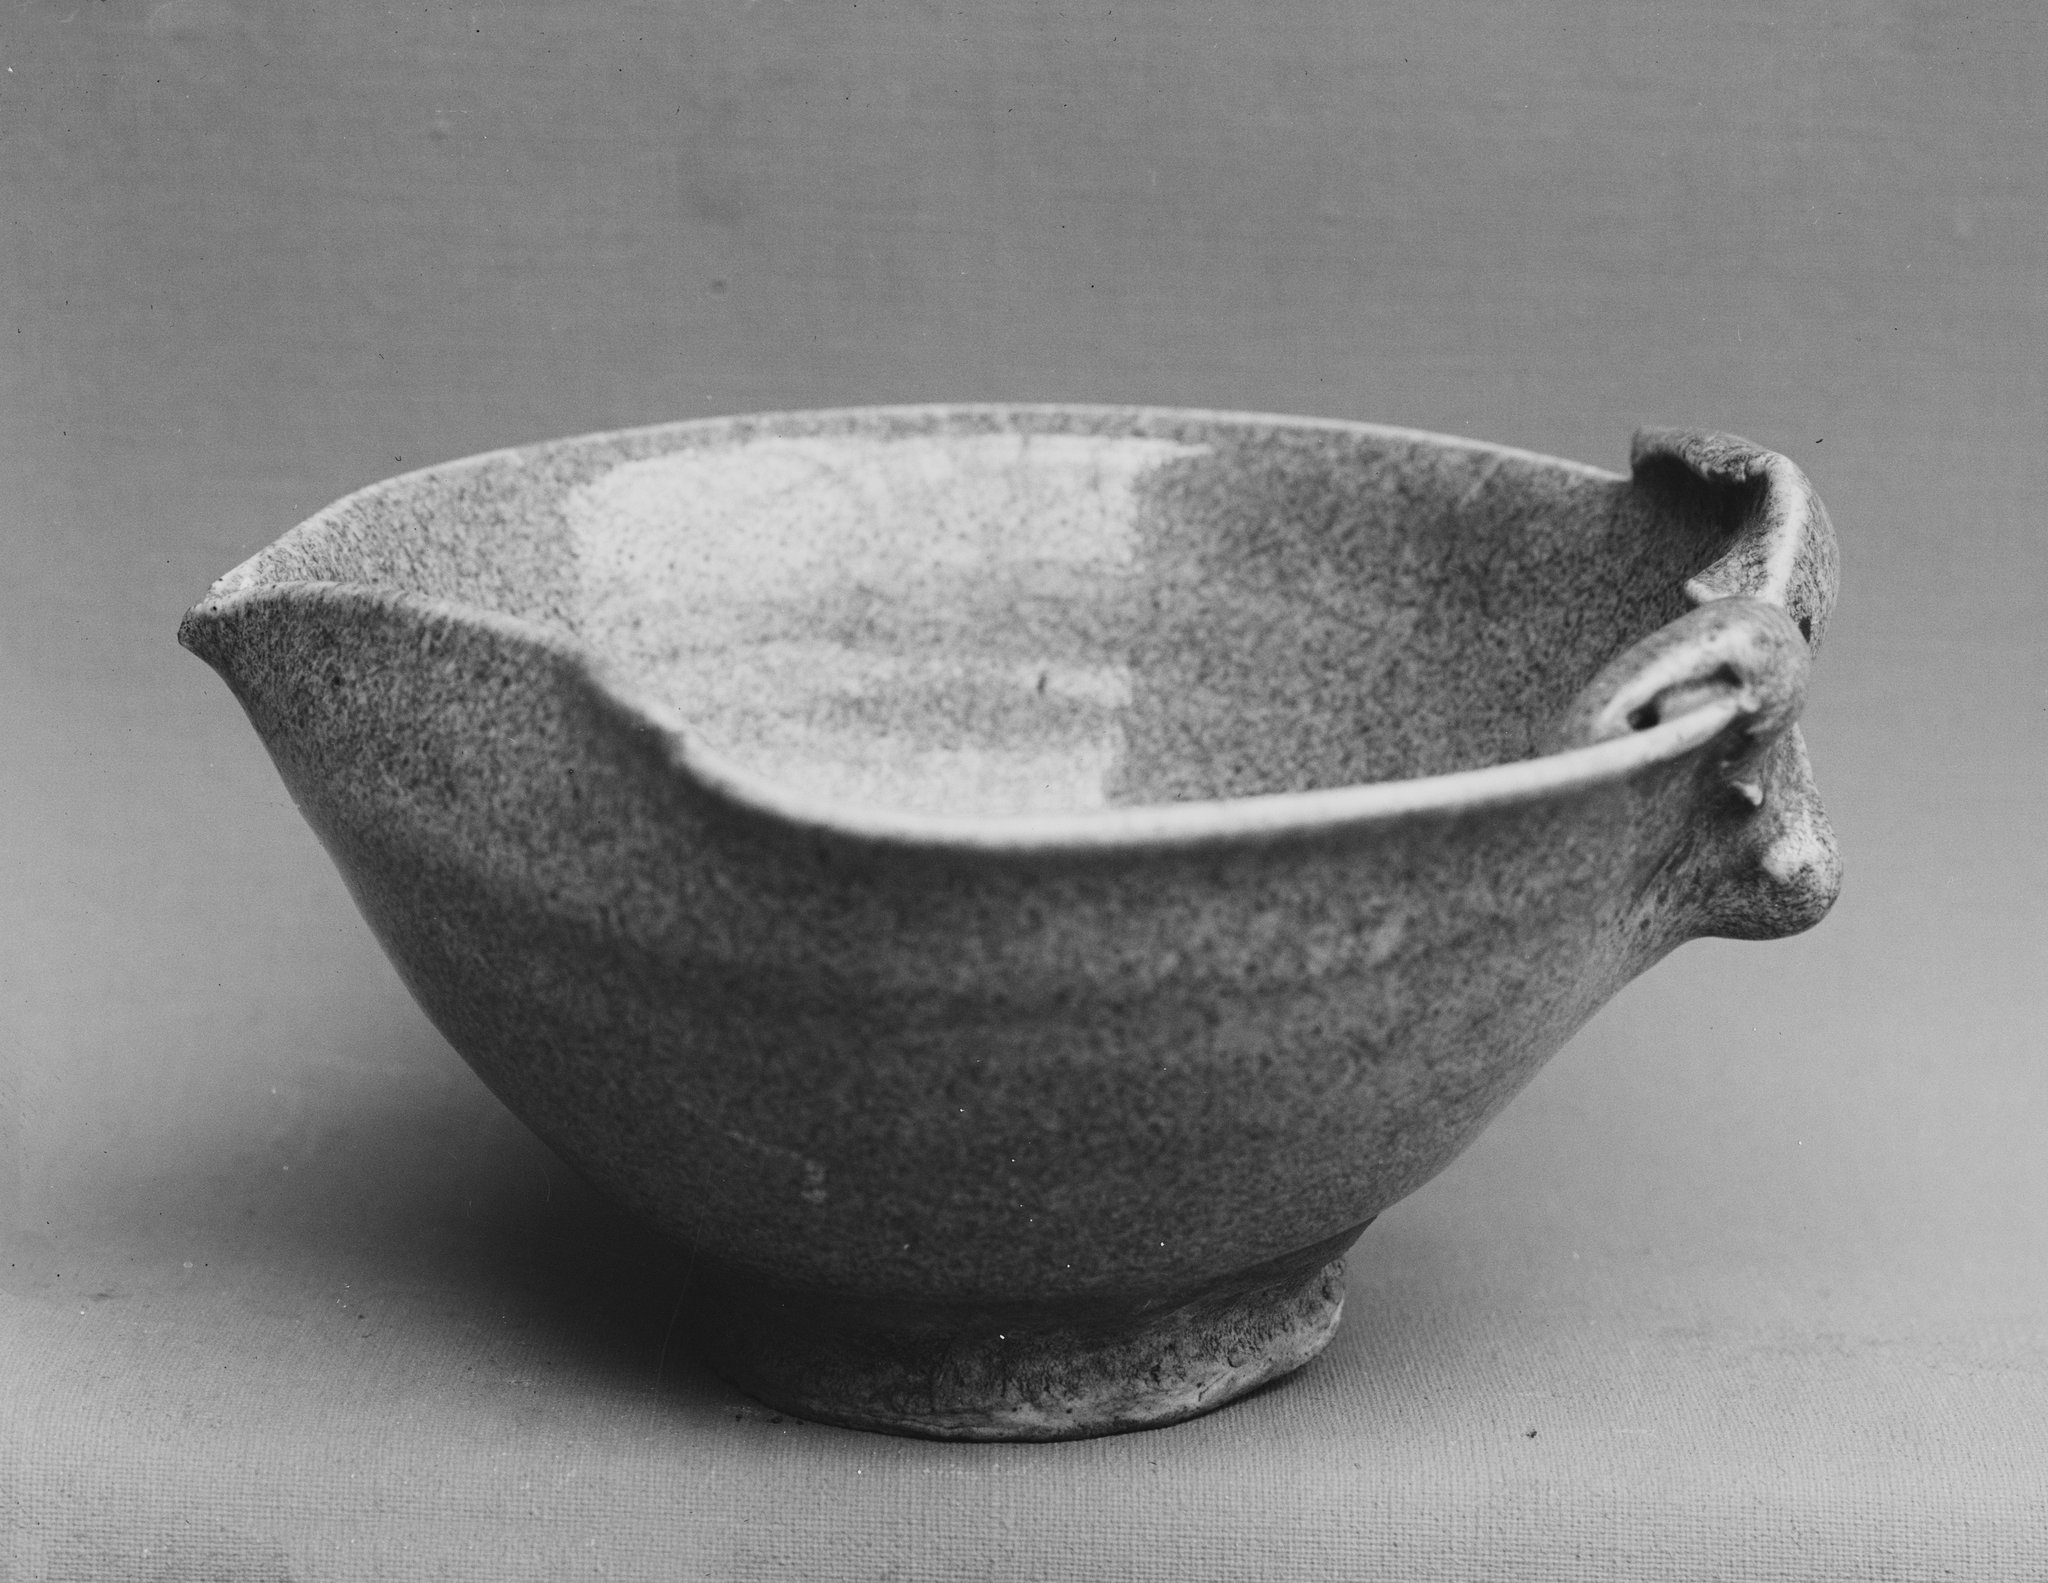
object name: cup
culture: japanese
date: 1750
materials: clay, glaze